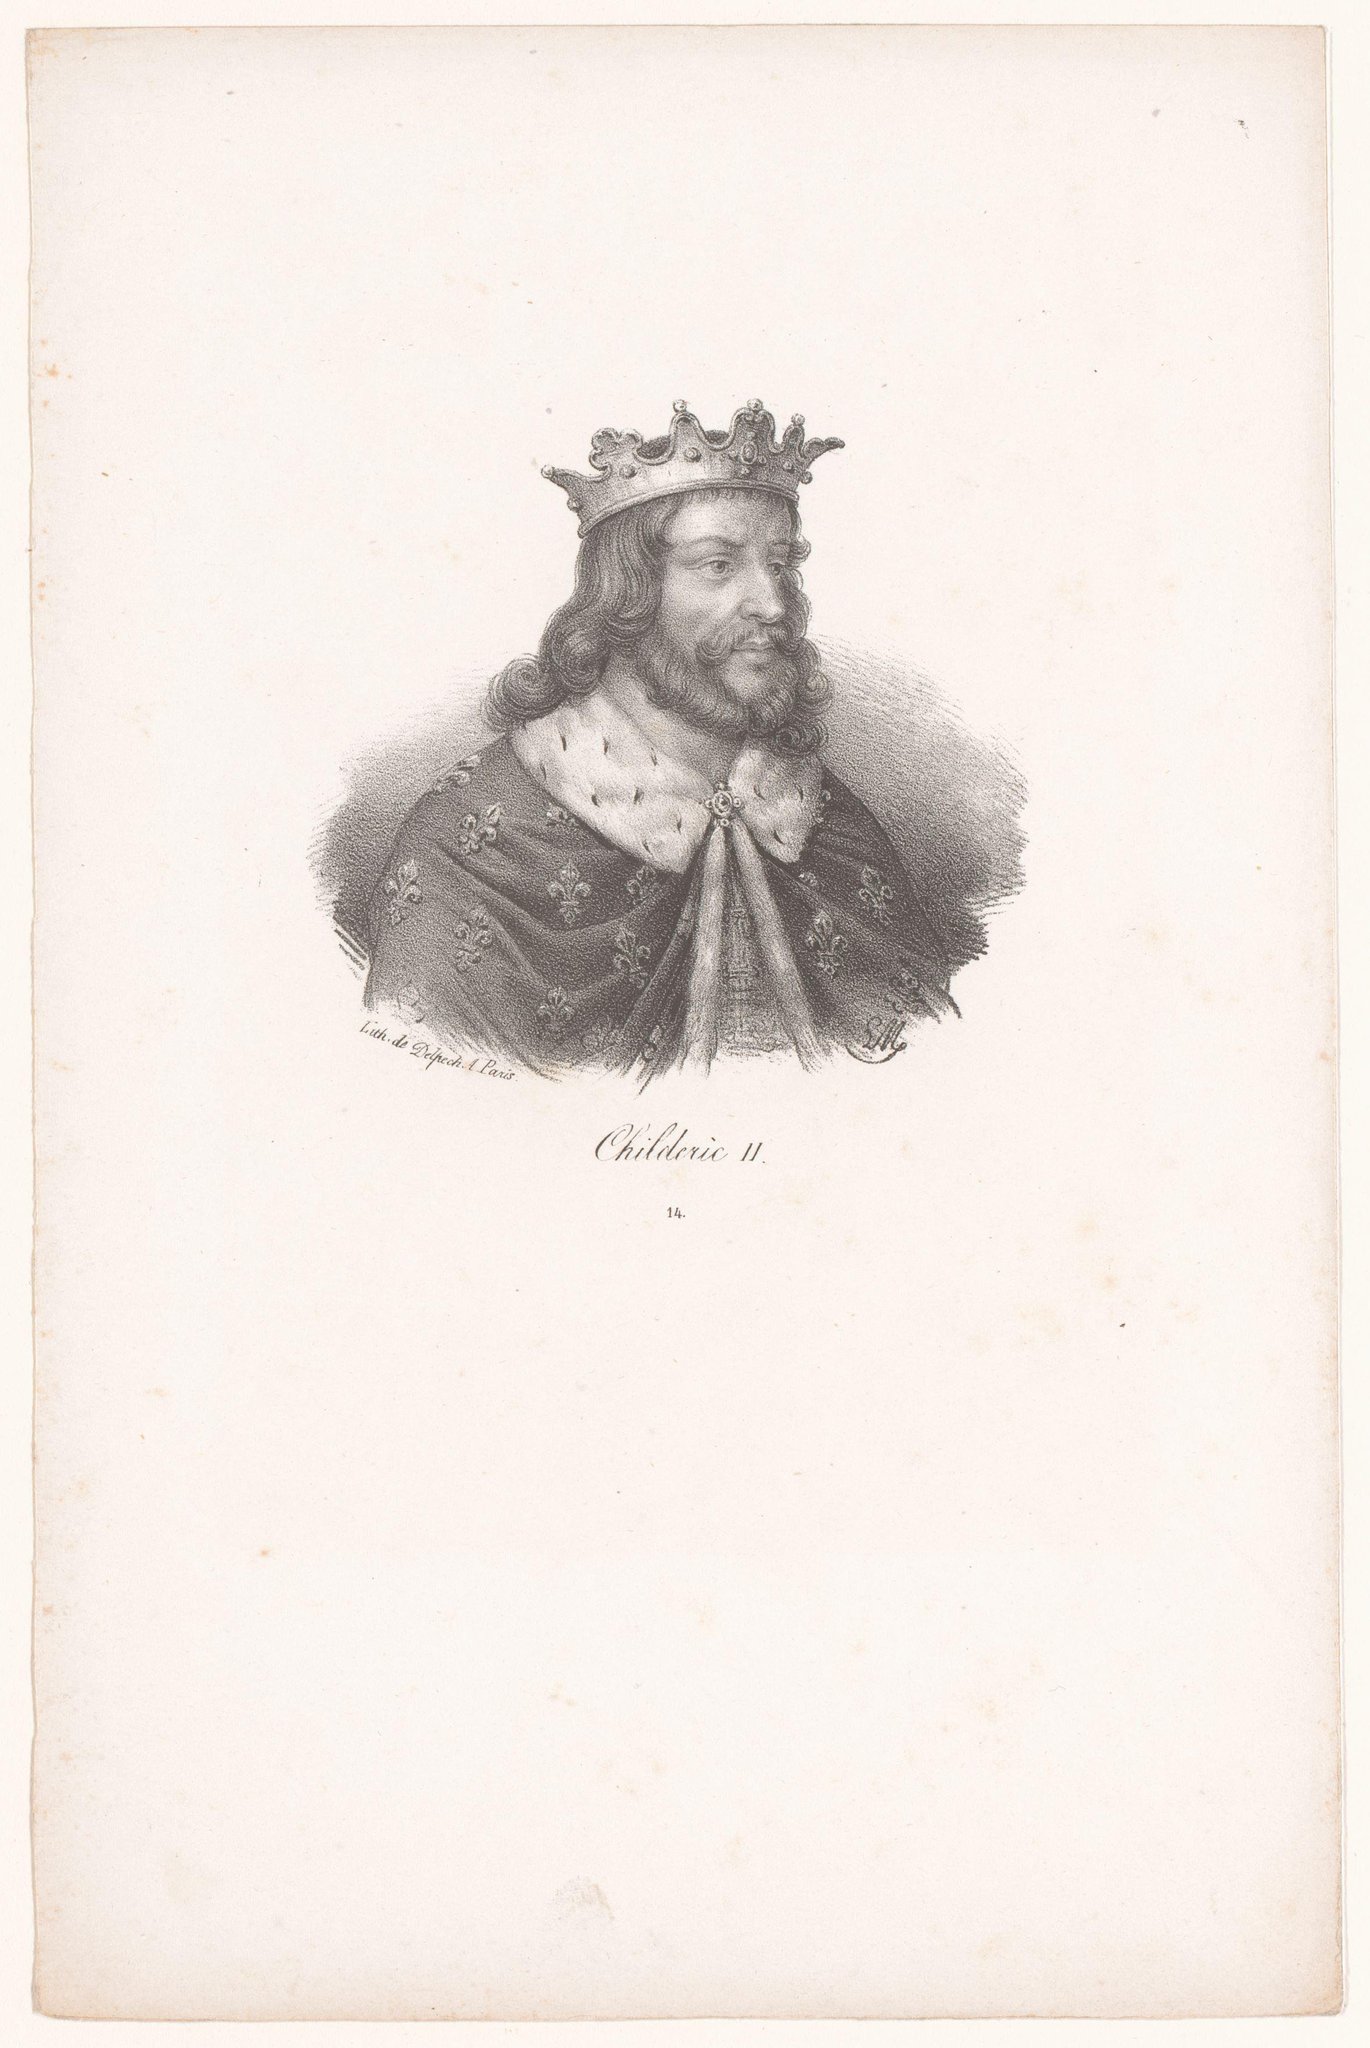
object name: print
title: Portret van Childerik II, koning van Austrasië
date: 1825-1842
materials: paper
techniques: lithograph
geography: paris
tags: historical persons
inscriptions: collector's mark: Lugt 2228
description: Prent waarschijnlijk gebruikt voor: Rois et reines de France: depuis l'origine de la monarchie jusqu'à nos jours. 3 dln. Parijs: veuve Delpech, 1833-1840. En/of voor: Iconographie française ou recueil des portraits des personnages les plus illustres qui ont paru en France depuis François premier jusqu'à la fin du règne de Louis XVI (…). Parijs: veuve Delpech, 1828. En/of voor: Iconographie française ou choix de deux cents portraits d'hommes et de femmes qui se sont acquis en France, depuis le règne de Charles VII jusqu'à la fin de celui de Louis XVI (…). Parijs: veuve Delpech, 1840. Mogelijk komt de prent ook voor in eerdere en/of latere publicaties uitgegeven door veuve Delpech of haar opvolger Rosselin.